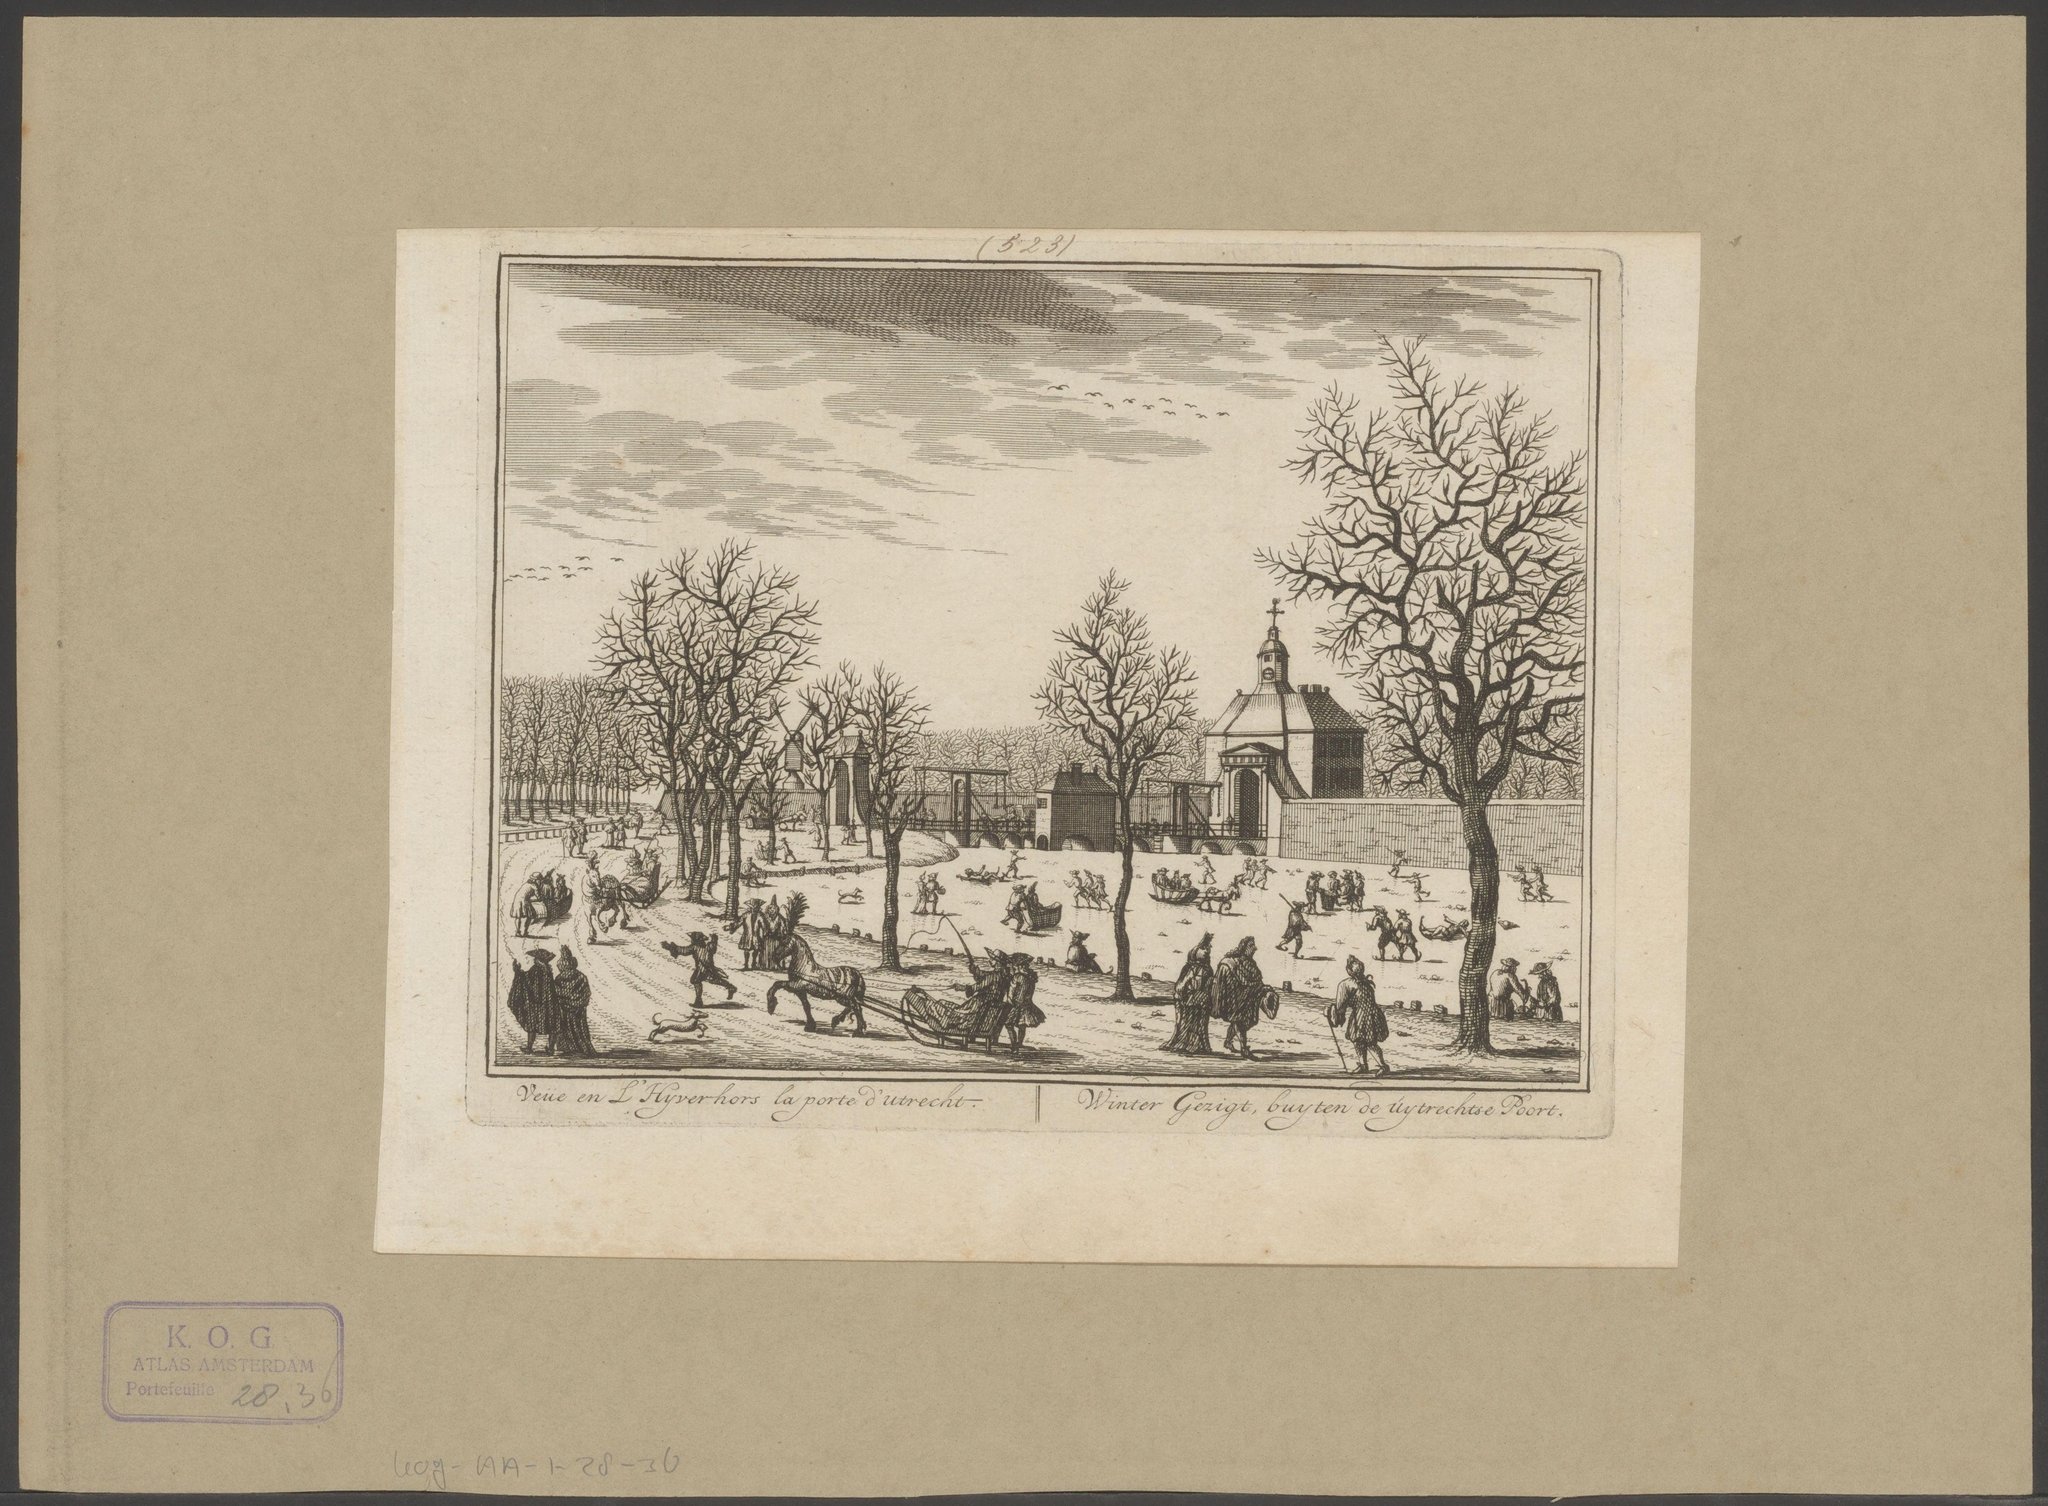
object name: print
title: Veüe en L'Hyverhors la porte d'Utrecht / Winter Gezigt, buyten de Uytrechtse Poort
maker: Anonymous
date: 1700-1749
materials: paper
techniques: engraving, etching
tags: skates (winter sports), sledge, sleigh (winter sports), city-gate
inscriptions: collector's mark: Lugt 1641b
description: Winterlandschap met de Utrechtsepoort vanaf de Amstel gezien. Op het bevroren water rijden schaatsers en door paarden getrokken sledes. Op het pad voor het water naar de dubbele ophaalbrug en de stadspoort toe eveneens ruiters, wandelaars en een door een paard getrokken slede. Onderwerpsrubriek binnen de Atlas Amsterdam: Poorten, verzamelbladen, C. Utrechtse Poort.